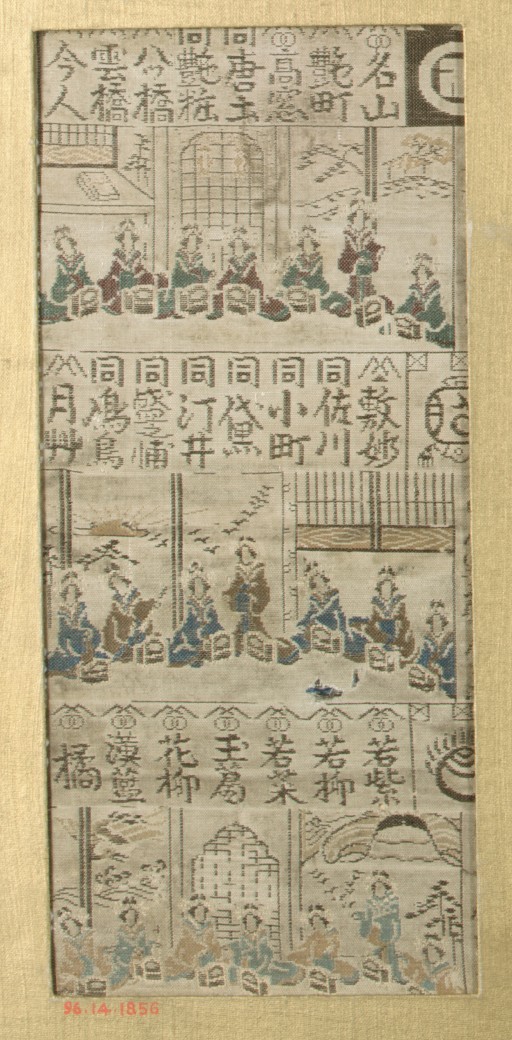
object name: piece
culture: japanese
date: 1701-1900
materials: silk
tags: human figures